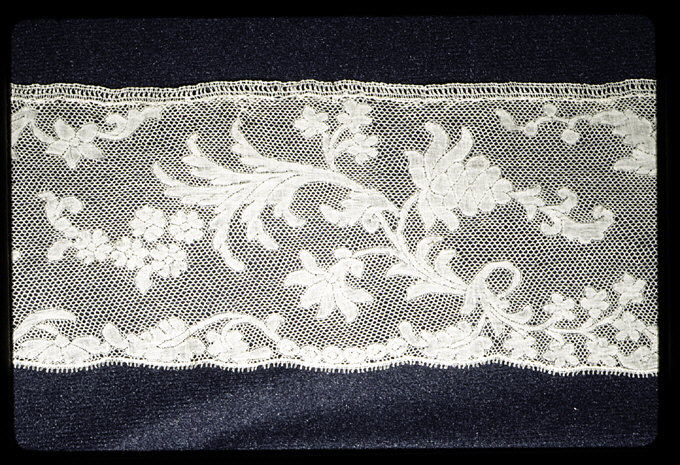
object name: border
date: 1701-1800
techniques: lace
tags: flowers